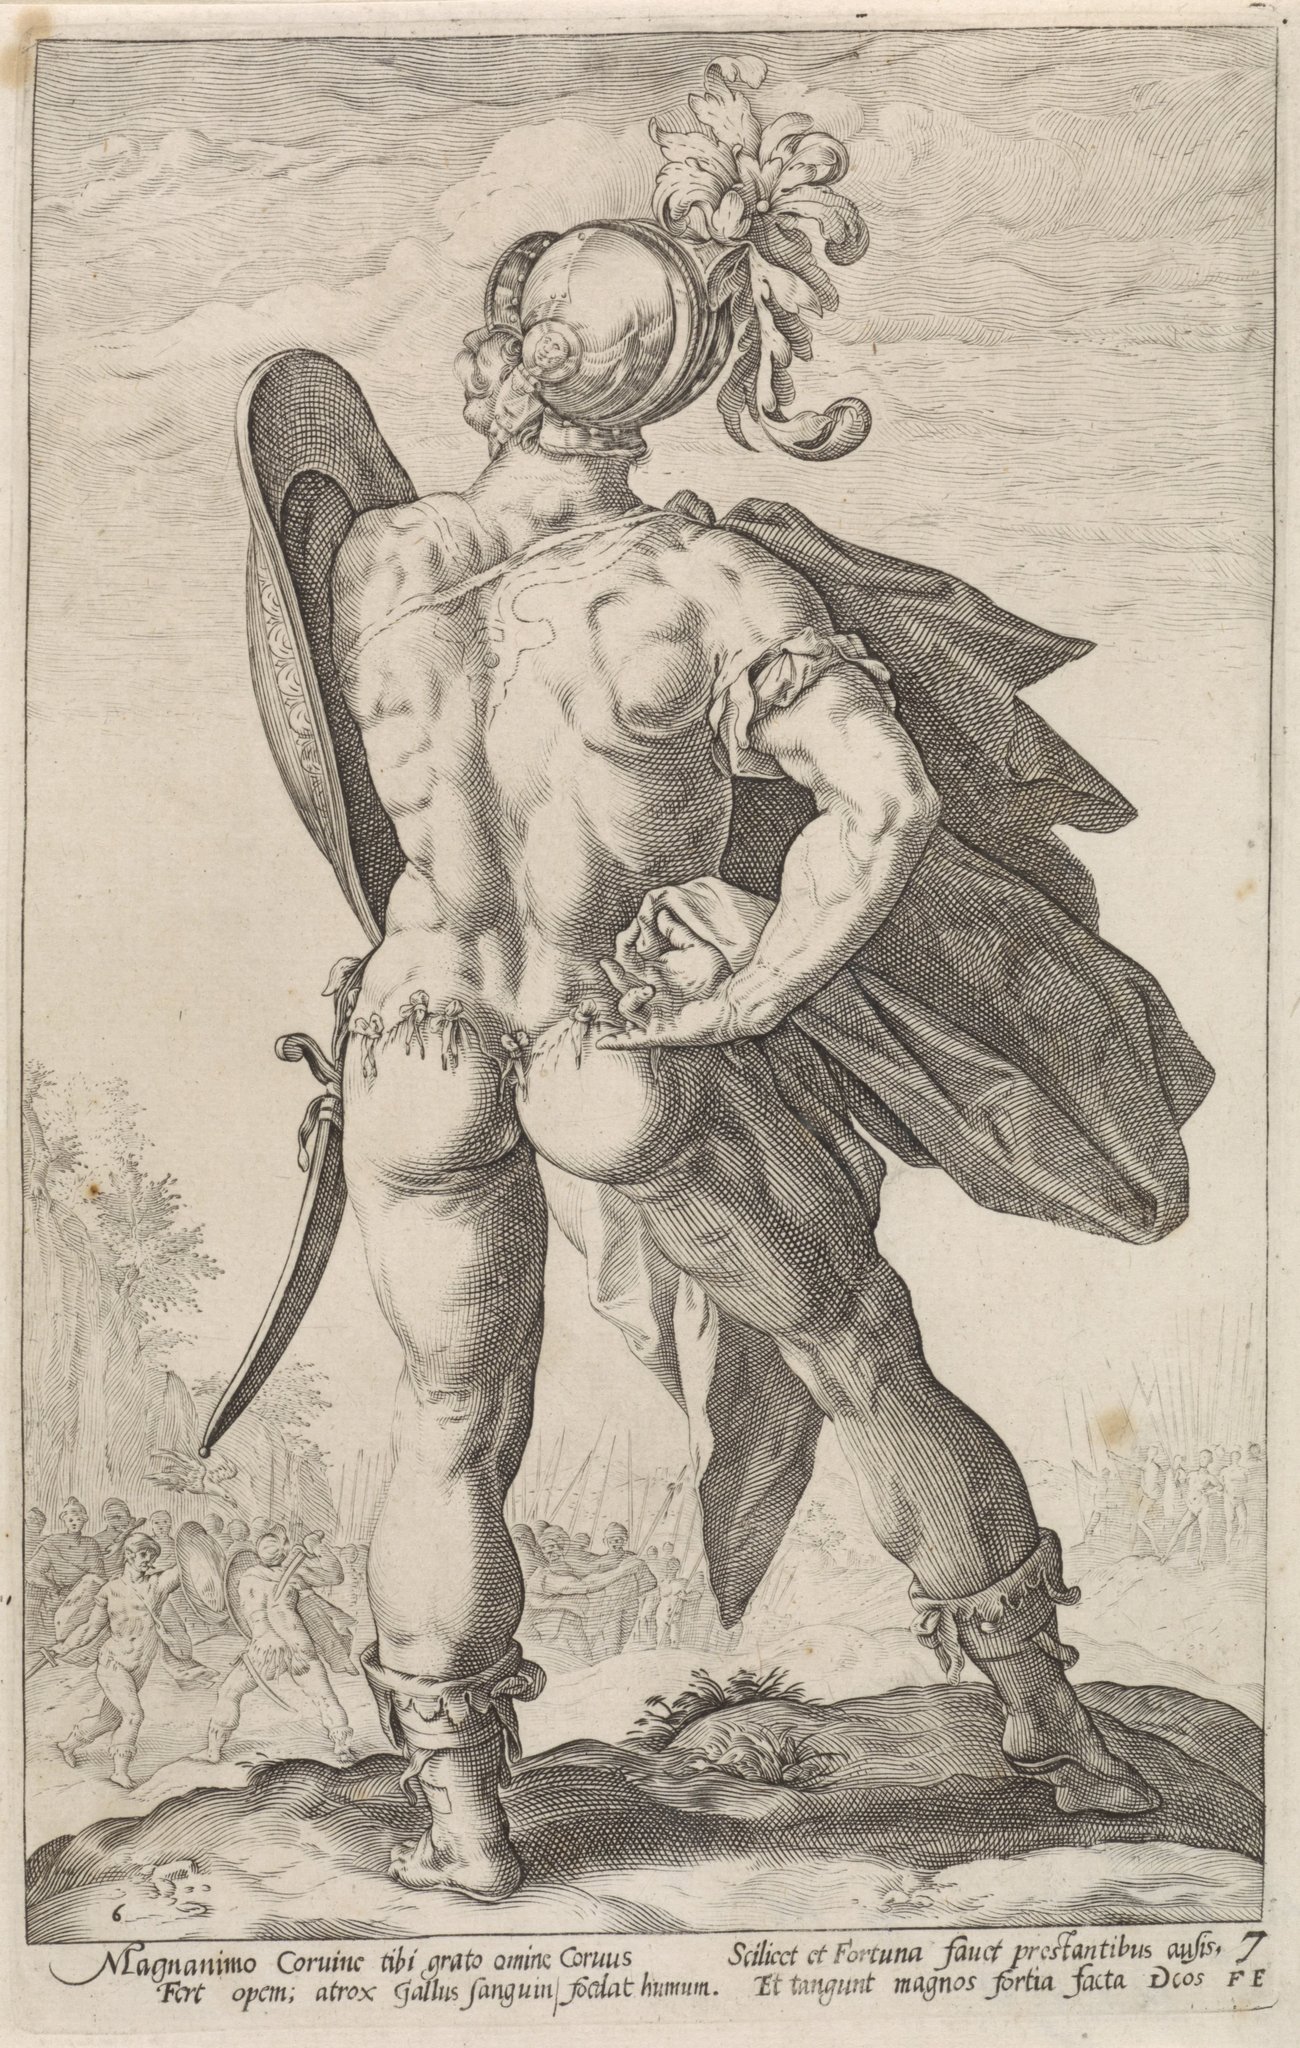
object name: print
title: Romeinse helden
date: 1645-1706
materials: paper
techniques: engraving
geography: amsterdam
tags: marcus valerius corvus (corvinus) victoriously fights a mighty gaul in single combat, assisted by a crow that attacks the face of the gaul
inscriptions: collector's mark: Lugt 2228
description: De held Marcus Valerius Corvus ten voeten uit, op de rug gezien, zijn schild opgeheven bij zijn linkerschouder. Op de achtergrond is te zien hoe hij met de hulp van een raaf (corvus) een Galliër verslaat. Onder de voorstelling twee maal twee versregels in Latijn.